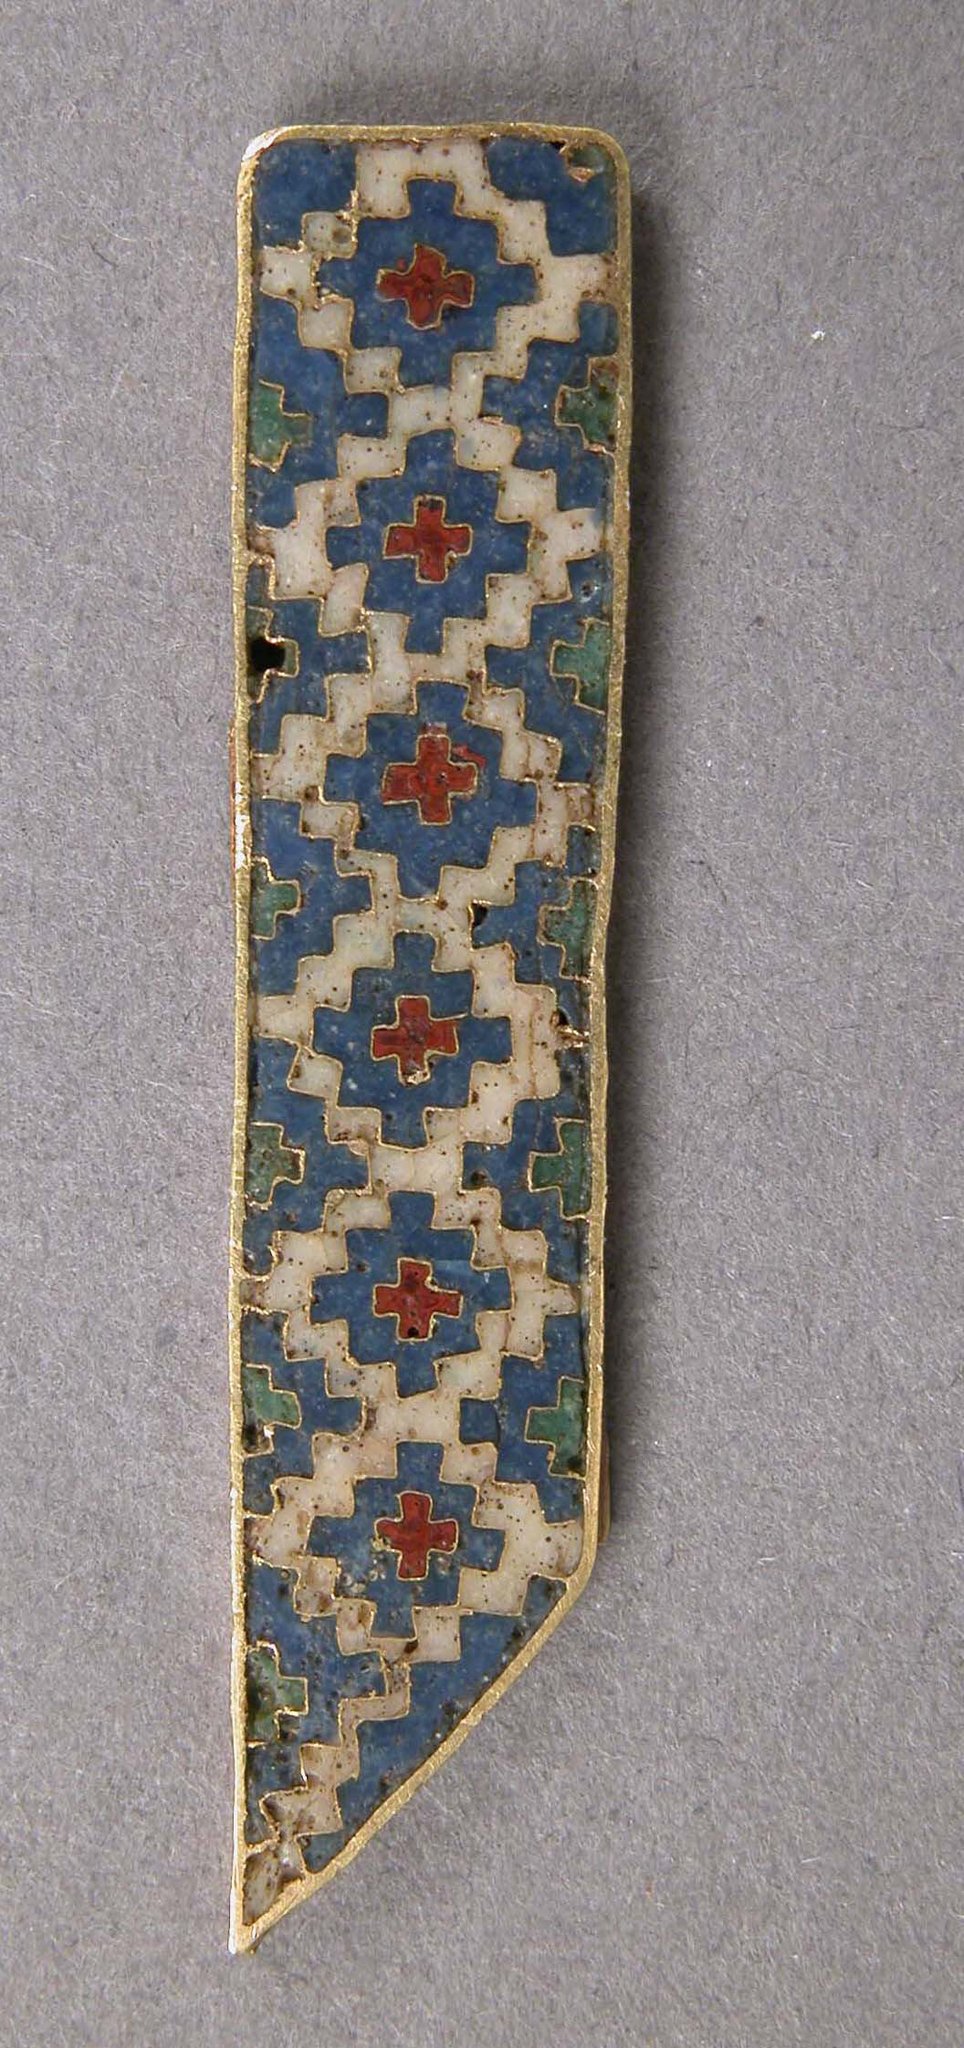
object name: border fragment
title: Element of a Border for an Icon Frame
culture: byzantine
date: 901-1000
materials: enamel, gold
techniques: enamel